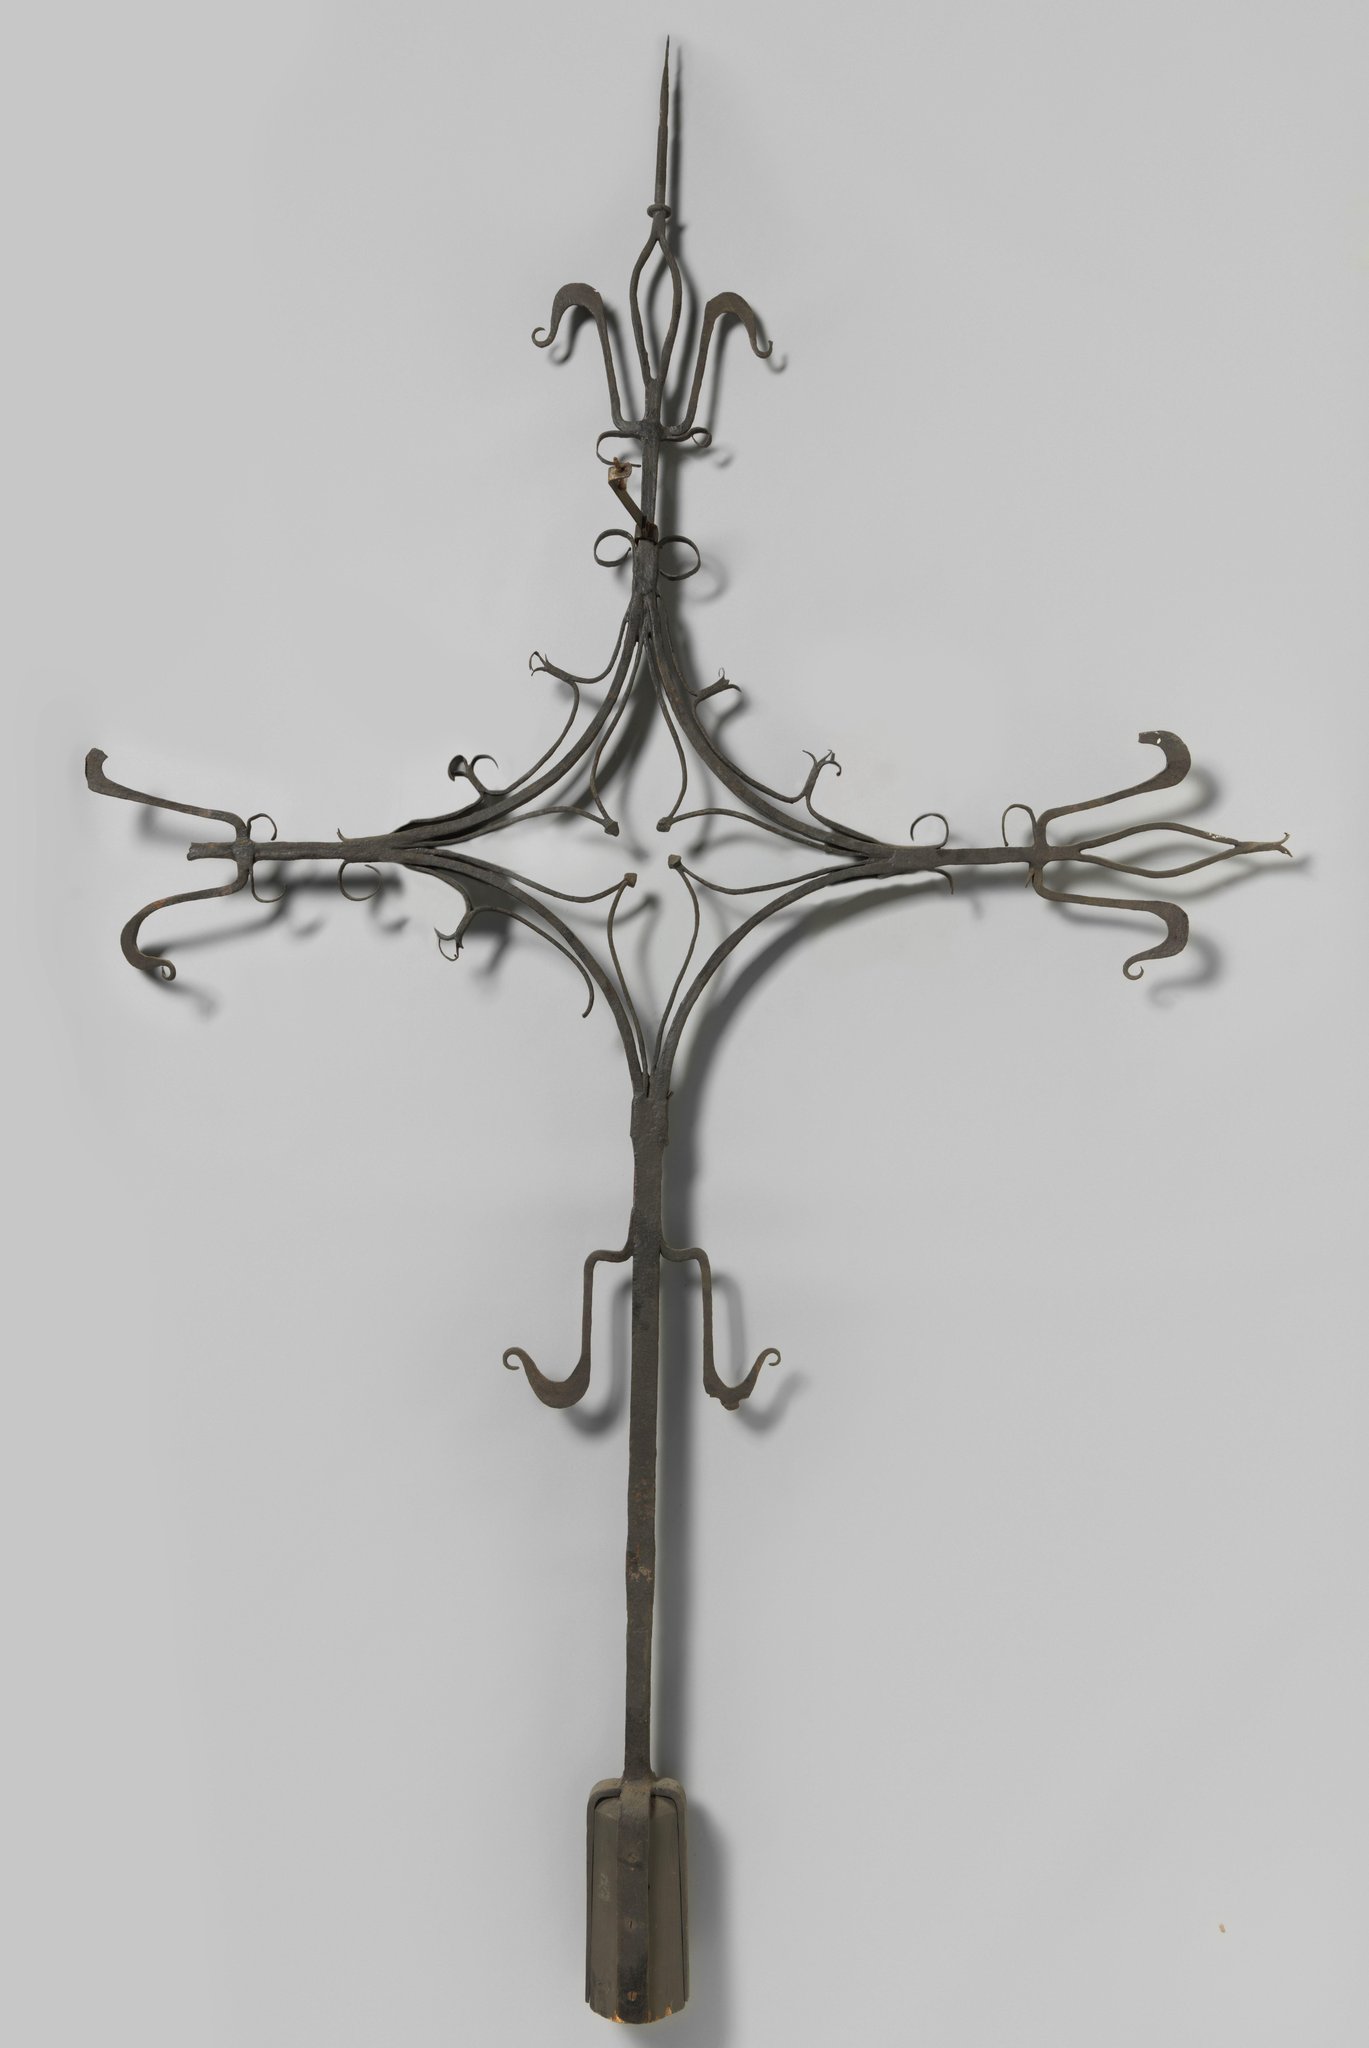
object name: torenkruis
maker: Anonymous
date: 1400-1950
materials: iron